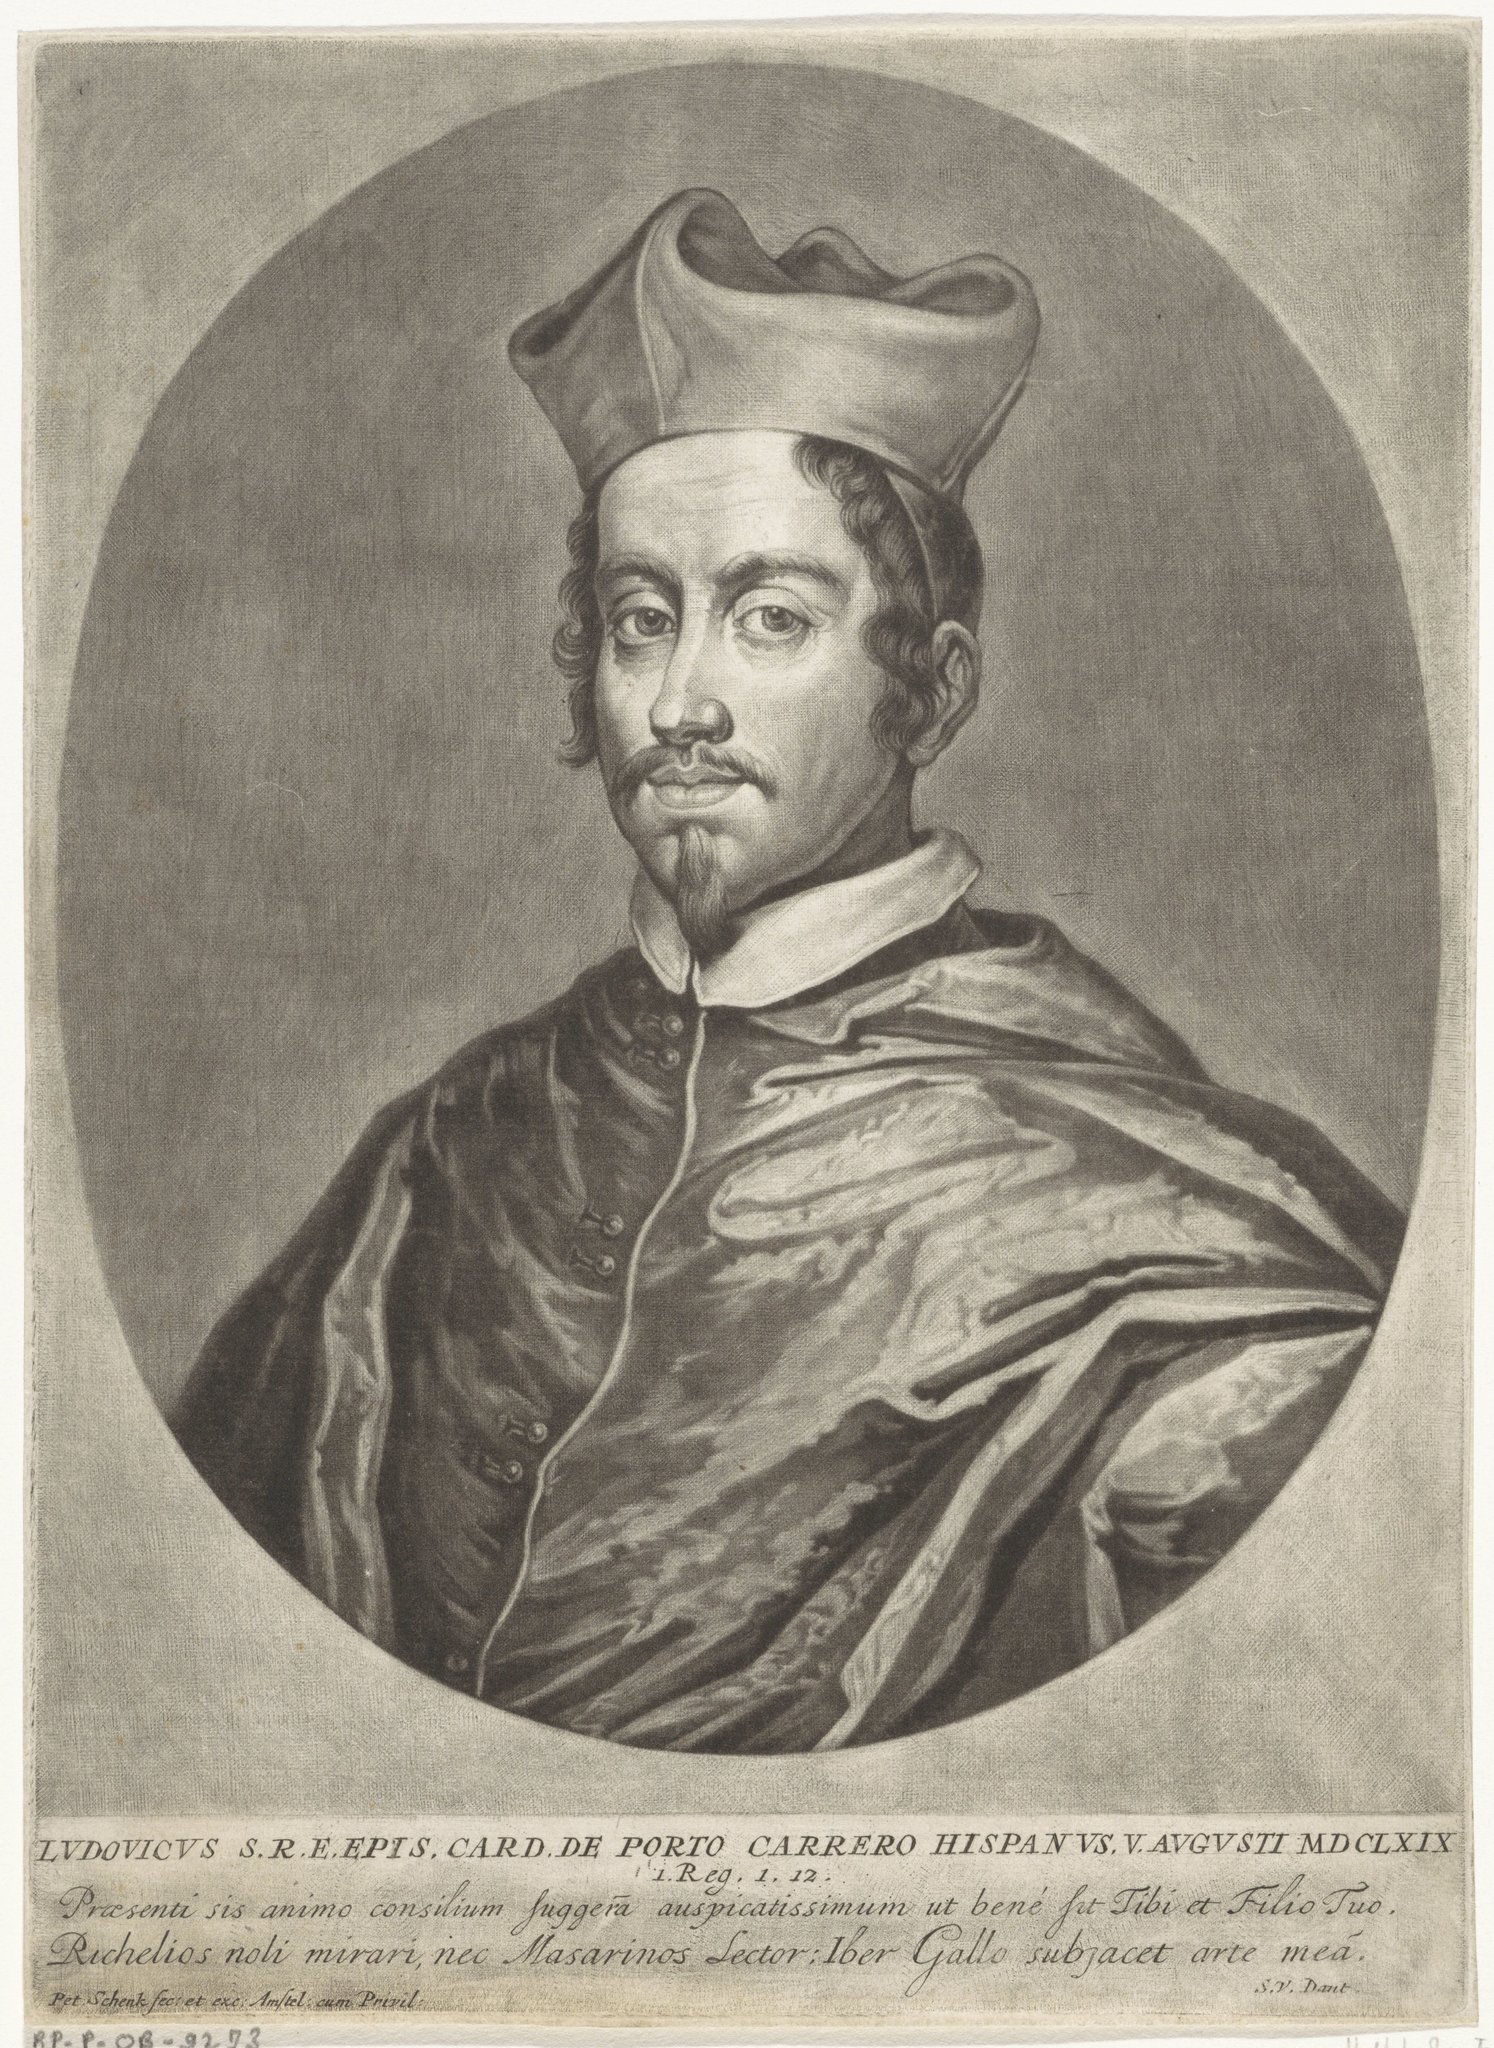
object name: print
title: Portret van de karninaal Luis Manuel Fernández de Portocarrero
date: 1670-1713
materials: paper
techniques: engraving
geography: amsterdam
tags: luis manuel fernandez de portocarrero